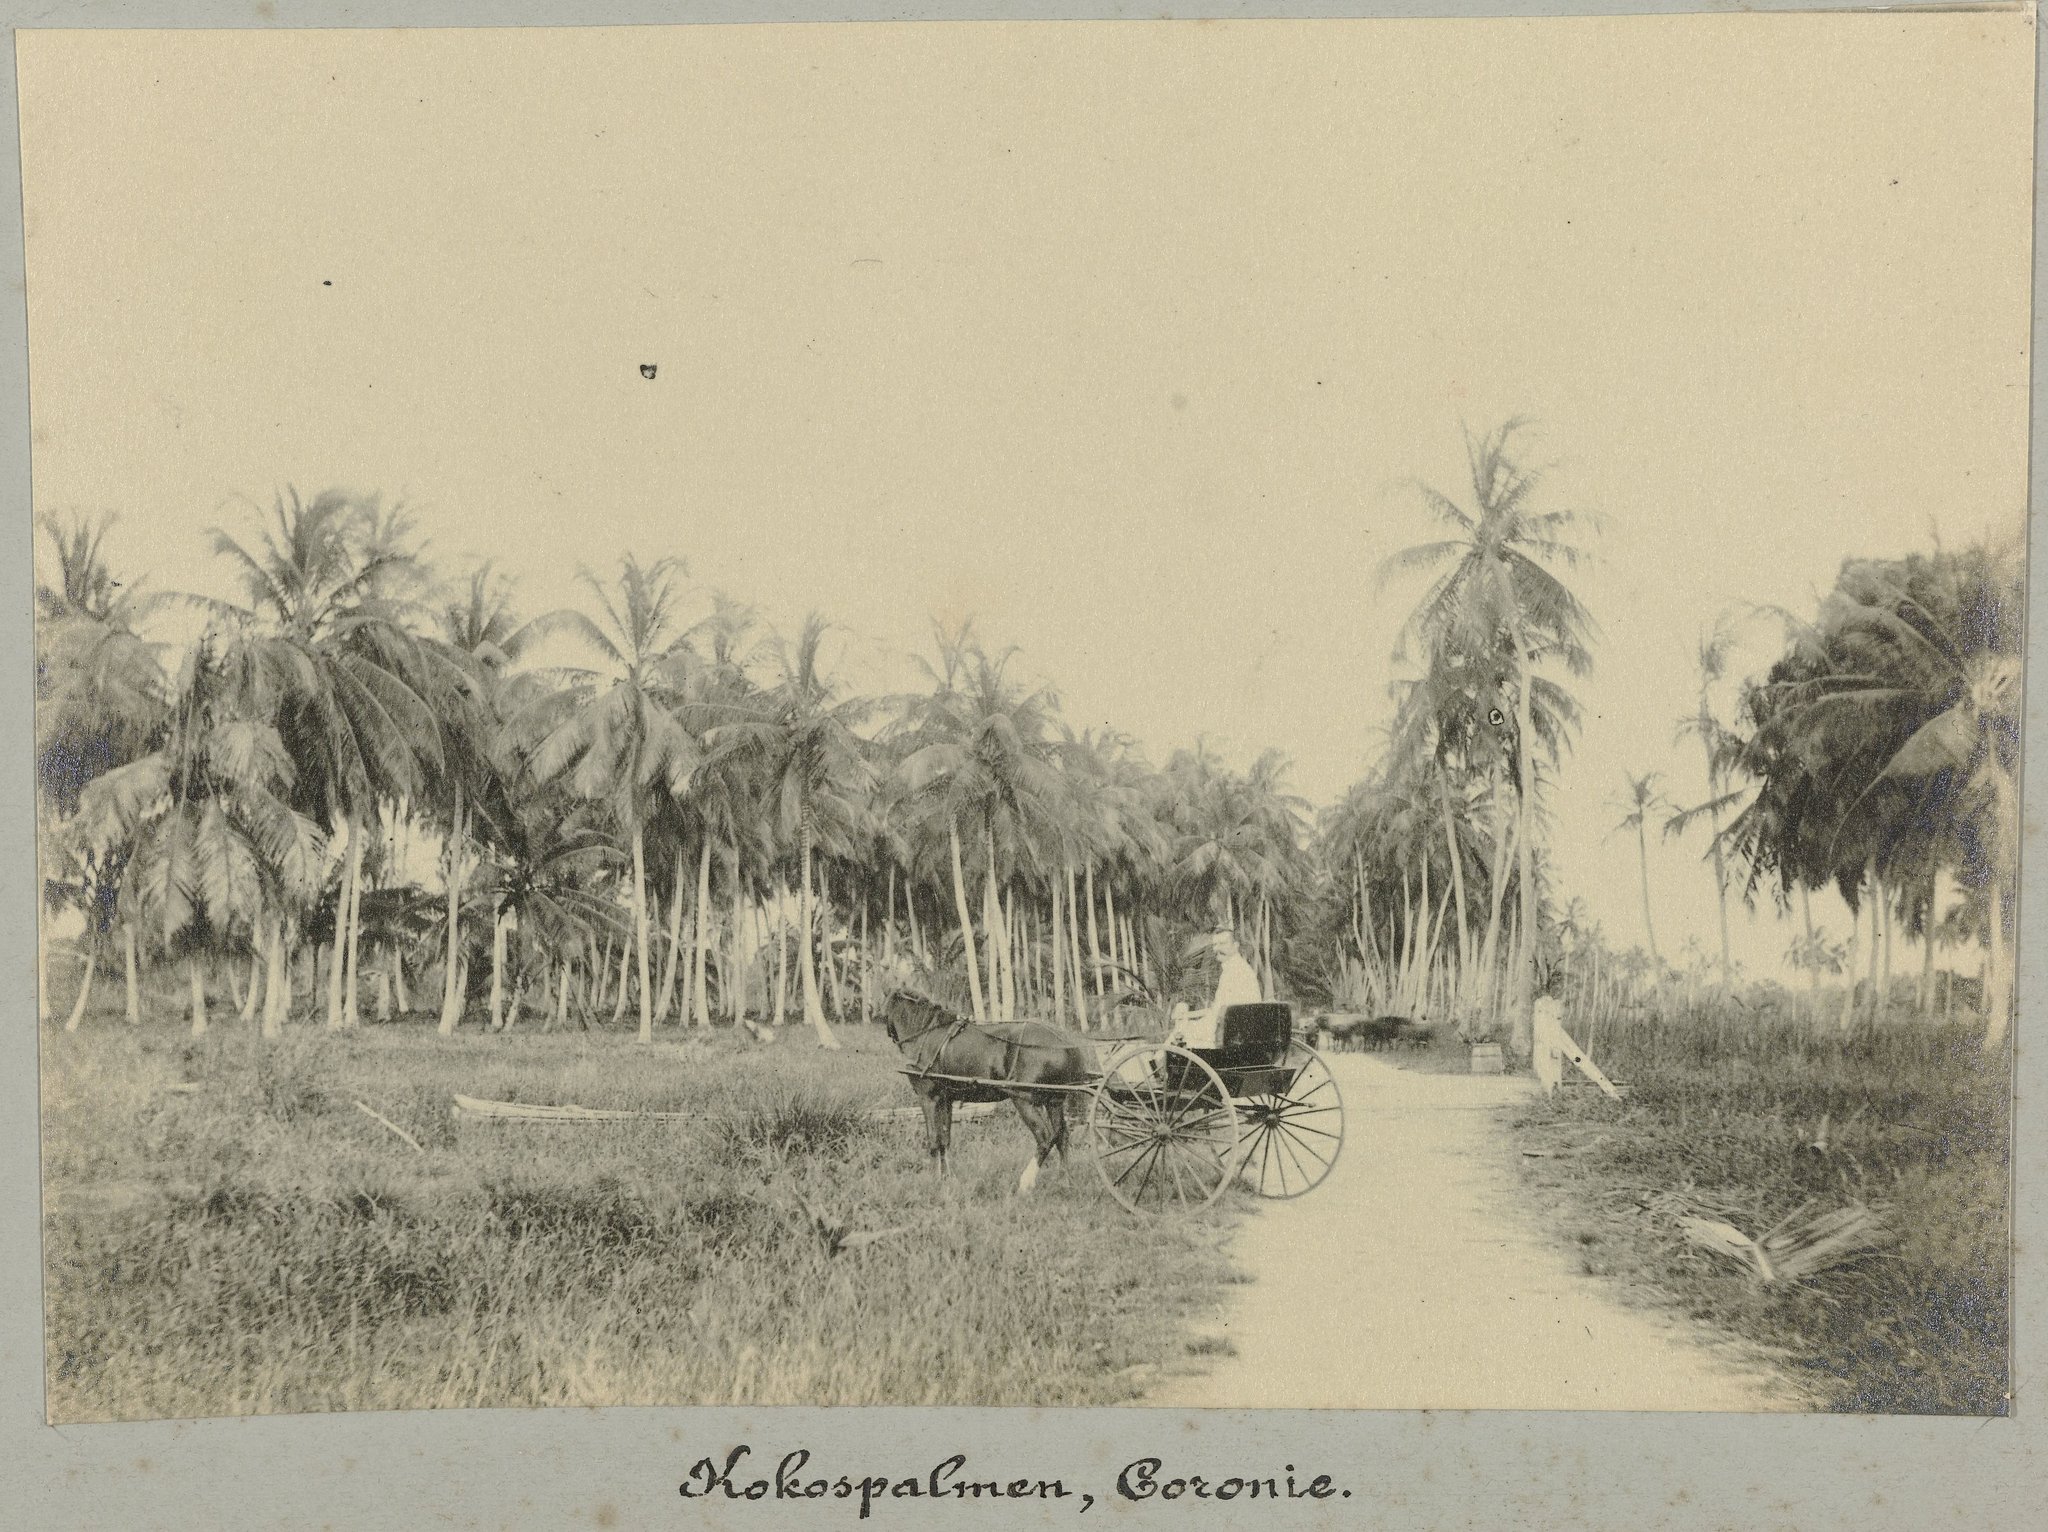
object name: photograph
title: Kokospalmen, Coronie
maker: hendrik doijer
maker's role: engineer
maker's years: 1863-1925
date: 1903-1910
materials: photographic support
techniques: gelatin silver print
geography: suriname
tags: suriname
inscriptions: inscription: ‘C15 / Kokospalmen, Coronie.’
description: Kokospalmen in Coronie. Op de voorgrond zit een Europese man in een door paard getrokken rijtuig. Onderdeel van het fotoalbum Souvenir de Voyage (deel 2), over het leven van de familie Doijer in en rond de plantage Ma Retraite in Suriname in de jaren 1903-1910.